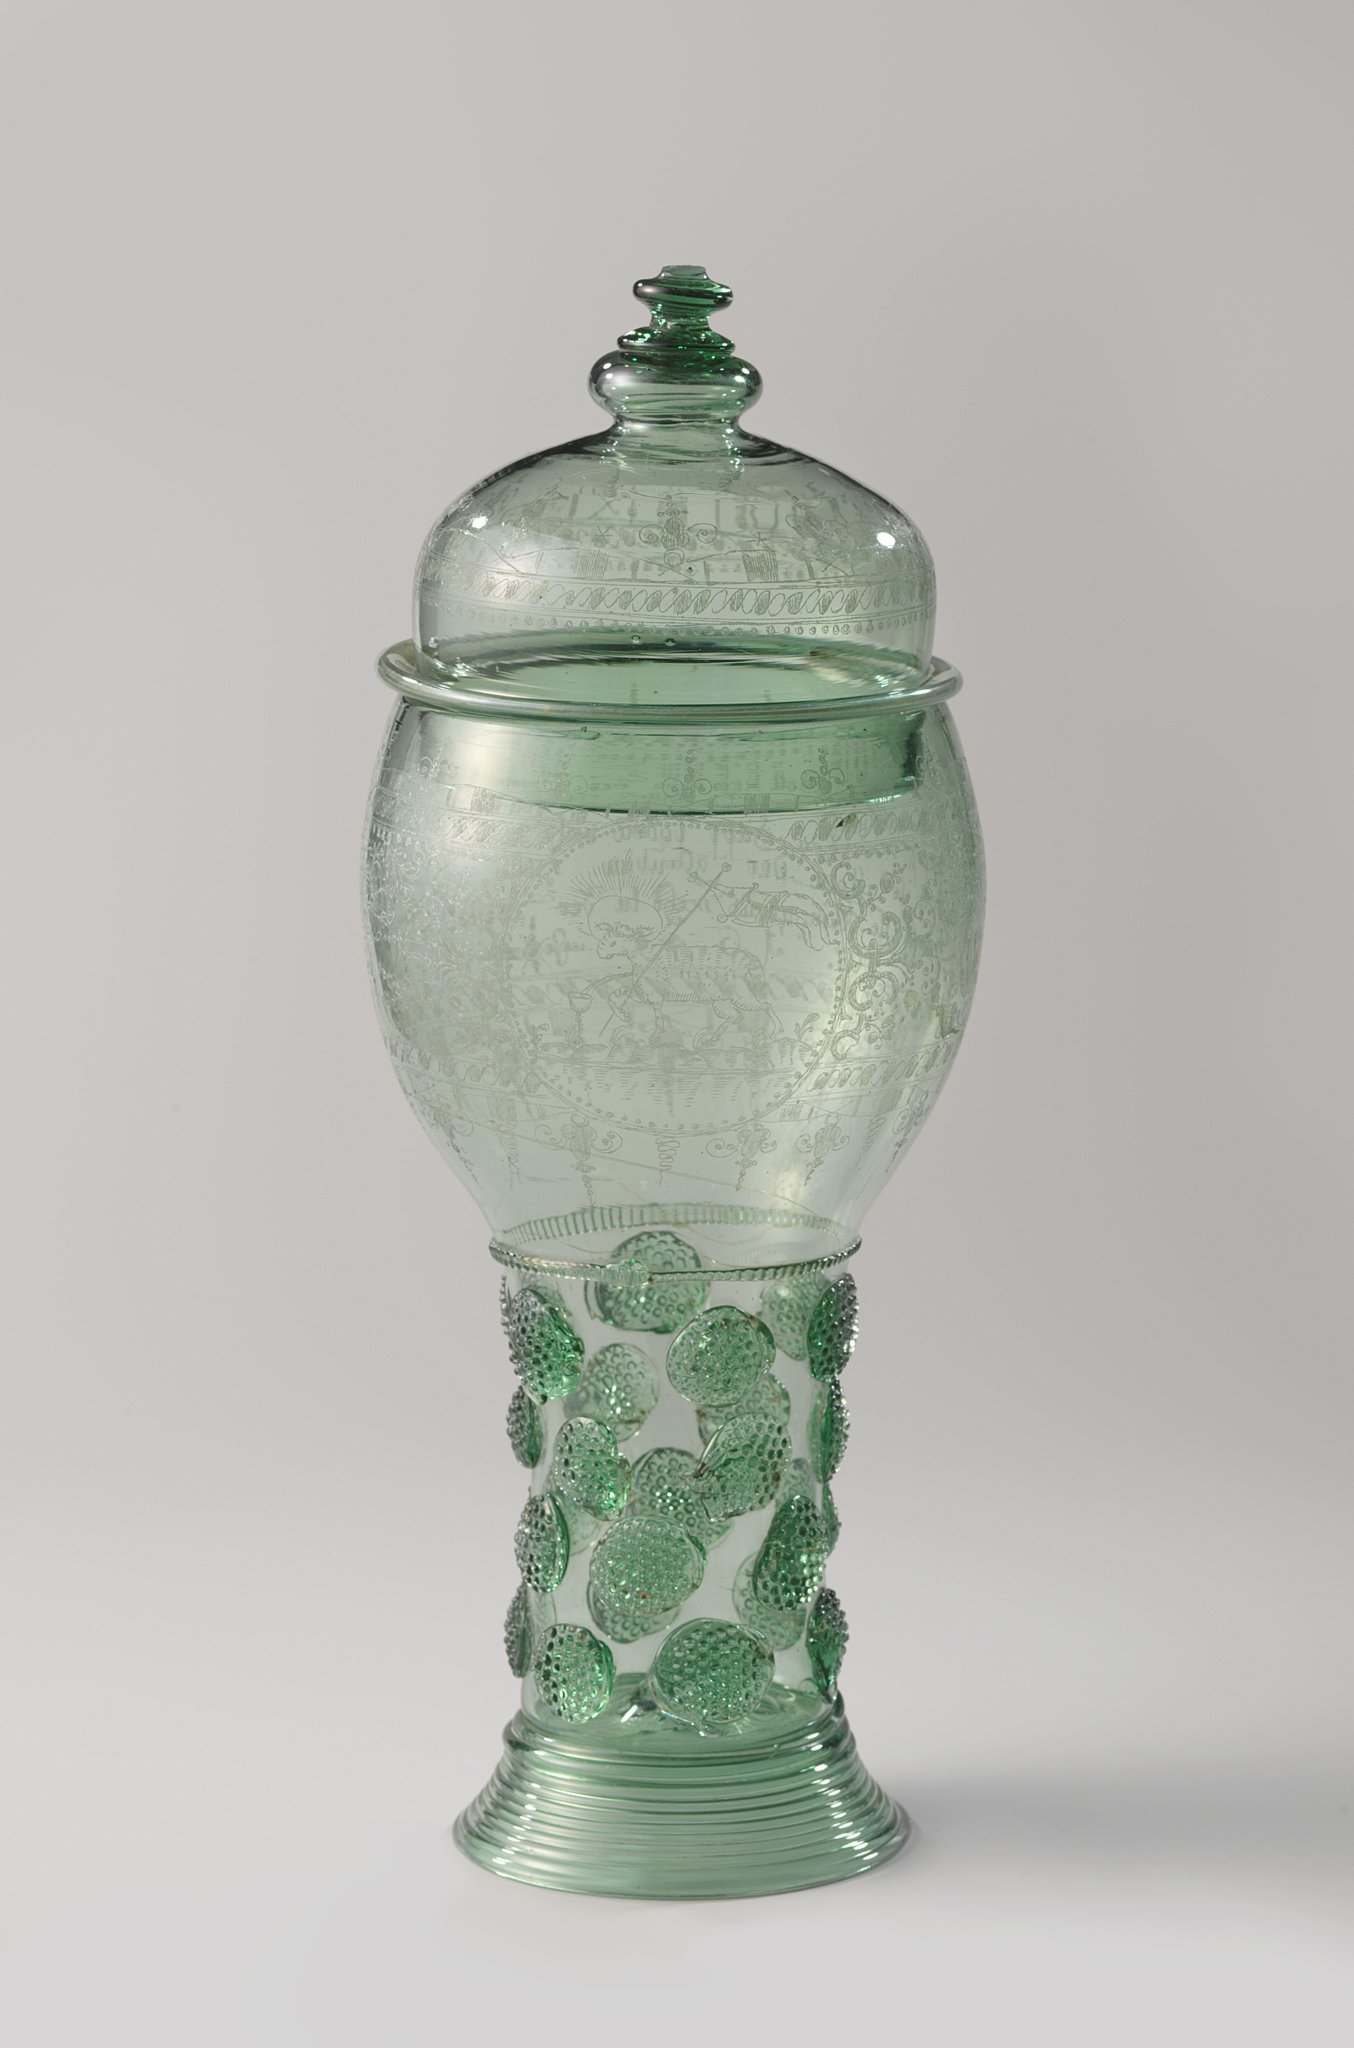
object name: lid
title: Roemer met Het Lam Gods en bloem- en bladmotieven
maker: Anonymous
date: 1659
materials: glass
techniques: diamond point engraving, glassblowing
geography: rhineland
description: Roemer van groen glas met vier rijen braamnoppen op de stam. Op de scheiding van de kelk en de stam een geknepen band. De kelk is in diamantgravure versierd met een voorstelling van het Lam Gods in een medaillon en een vierregelige Duitse tekst: ALLEIN AUFF GOTT SETS DEIN VERTRAUEN, AUFF MENSCHEN HILFF SOLLEN NICHT BAUEN, GOTT IST ALLEIN DER GLAUBEN HELLT, SONST IST KEIN GLAUB MEHR IN DER WELT. Daaronder: Ao 1659. Tussen medaillon en opschrift bloem- en bladmotieven in Renaissance-stijl. Langs boven- en onderzijde van de kelk is een smalle slingerrand en een rij fleurons aangebracht. Deze versiering is op het deksel herhaald. Opmerking: roemer gebroken en gelijmd; knopje deksel ontbreekt.